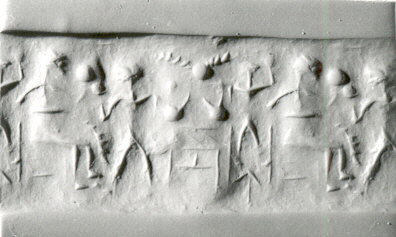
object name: cylinder seal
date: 1900-1800 BCE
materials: stone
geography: syria